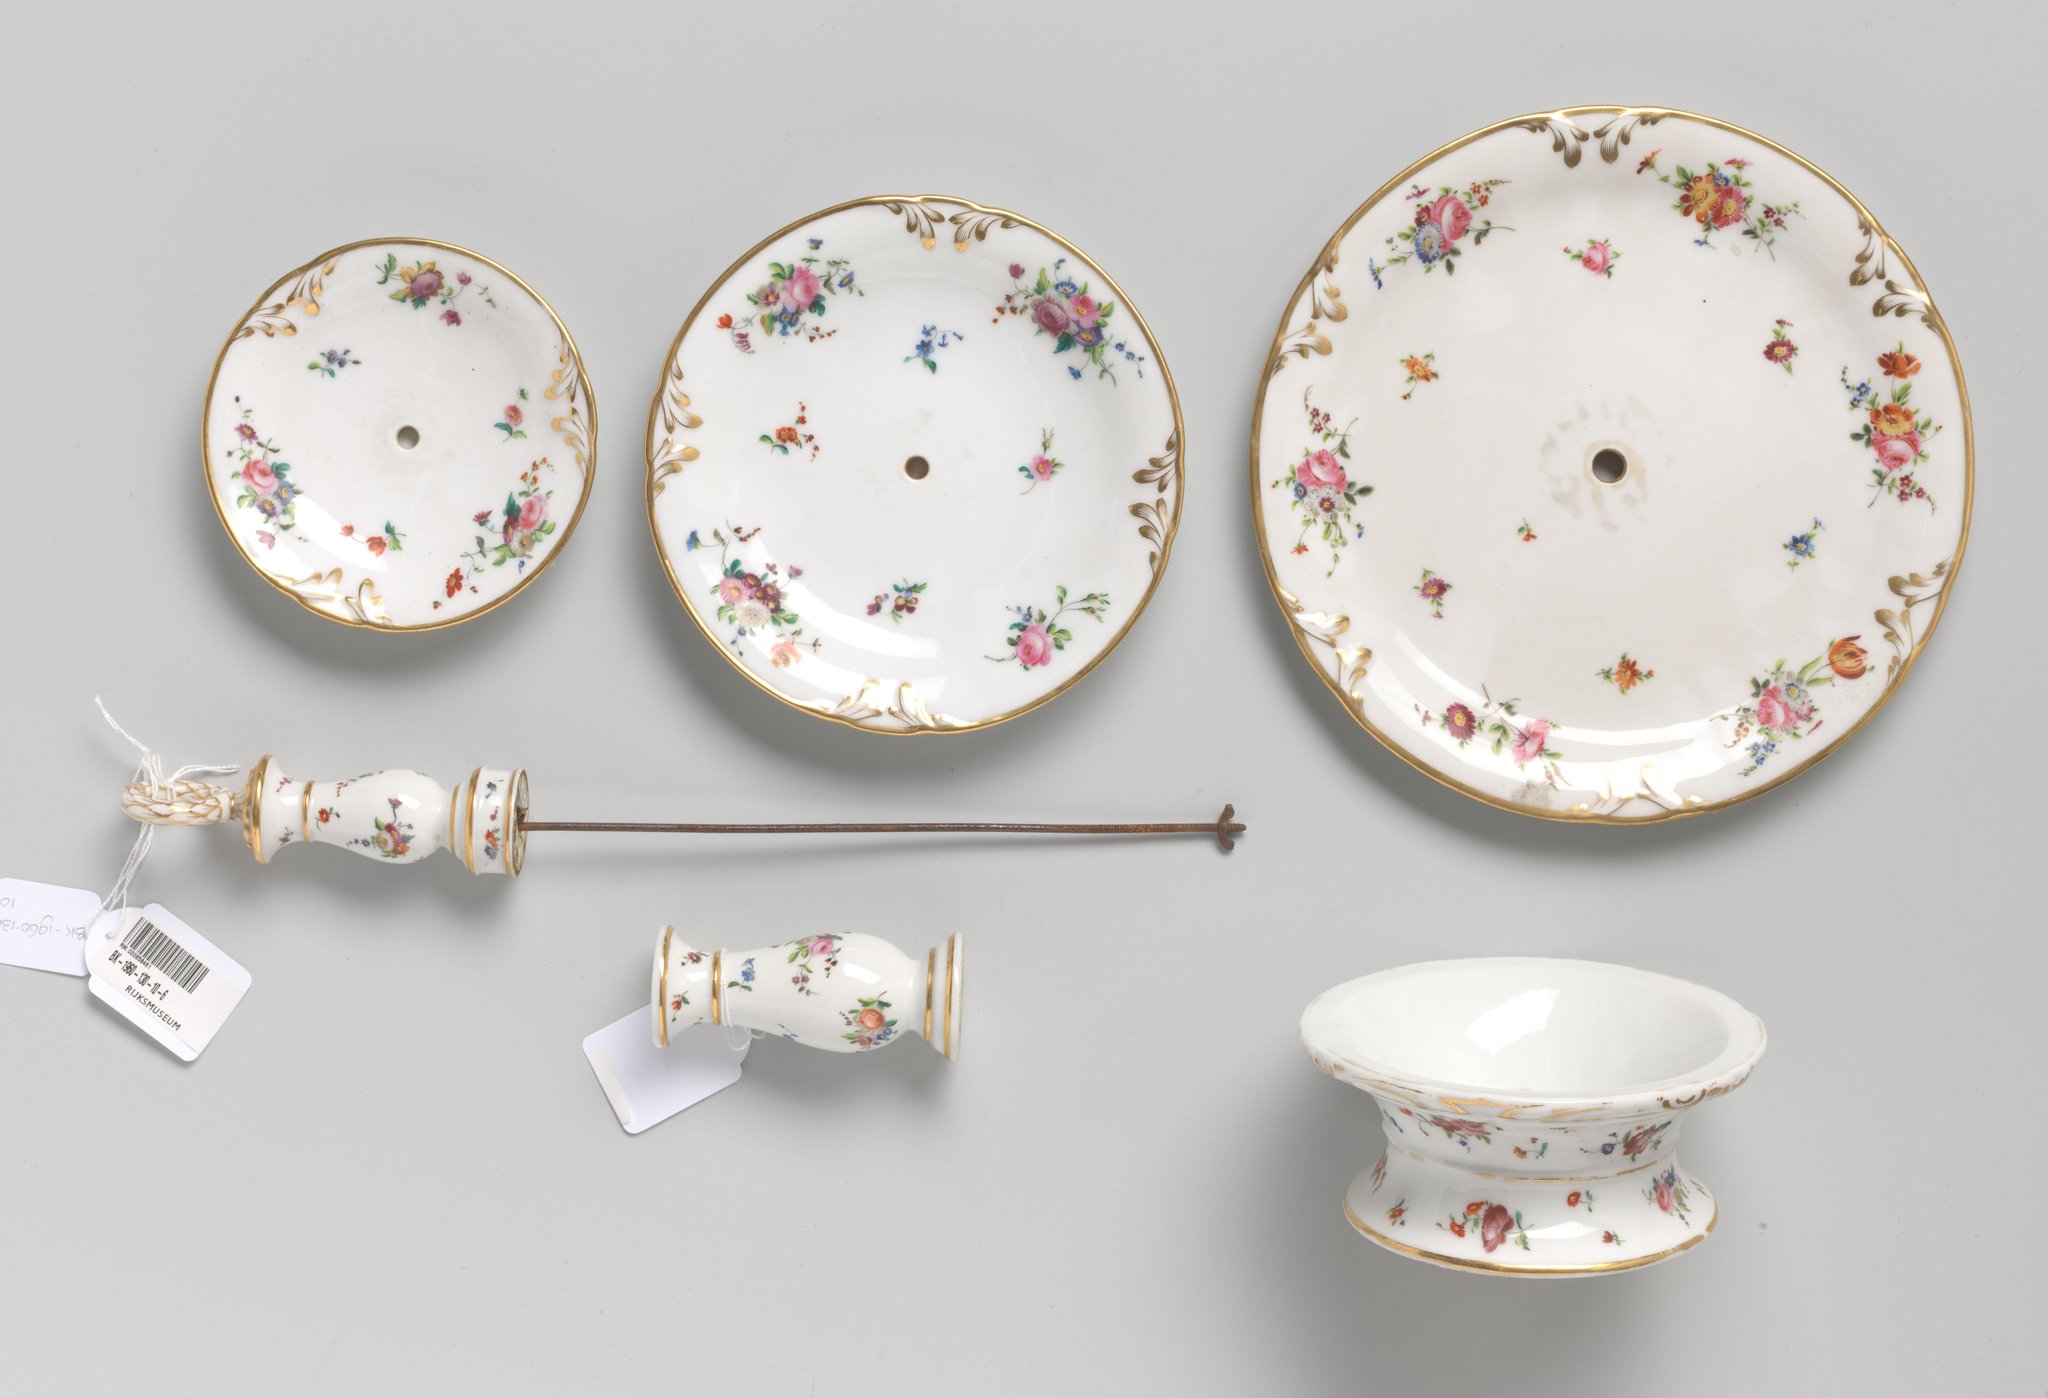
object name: service set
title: Dish of an etagere with bouquets and flower sprays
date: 1839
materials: glaze, gold, paint, porcelain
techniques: firing, forming, gilding, turning, vitrification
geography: paris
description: De grootste schaal van een étagère van porselein, beschilderd op het glazuur in blauw, rood, roze, groen, geel, paars, zwart en goud. Versierd op de voor- en achterzijde met boeketten van verschillende bloemen en strooibloemen. Vanuit de gelobde, gouden rand, gemodelleerde bladranken, aangezet met goud.